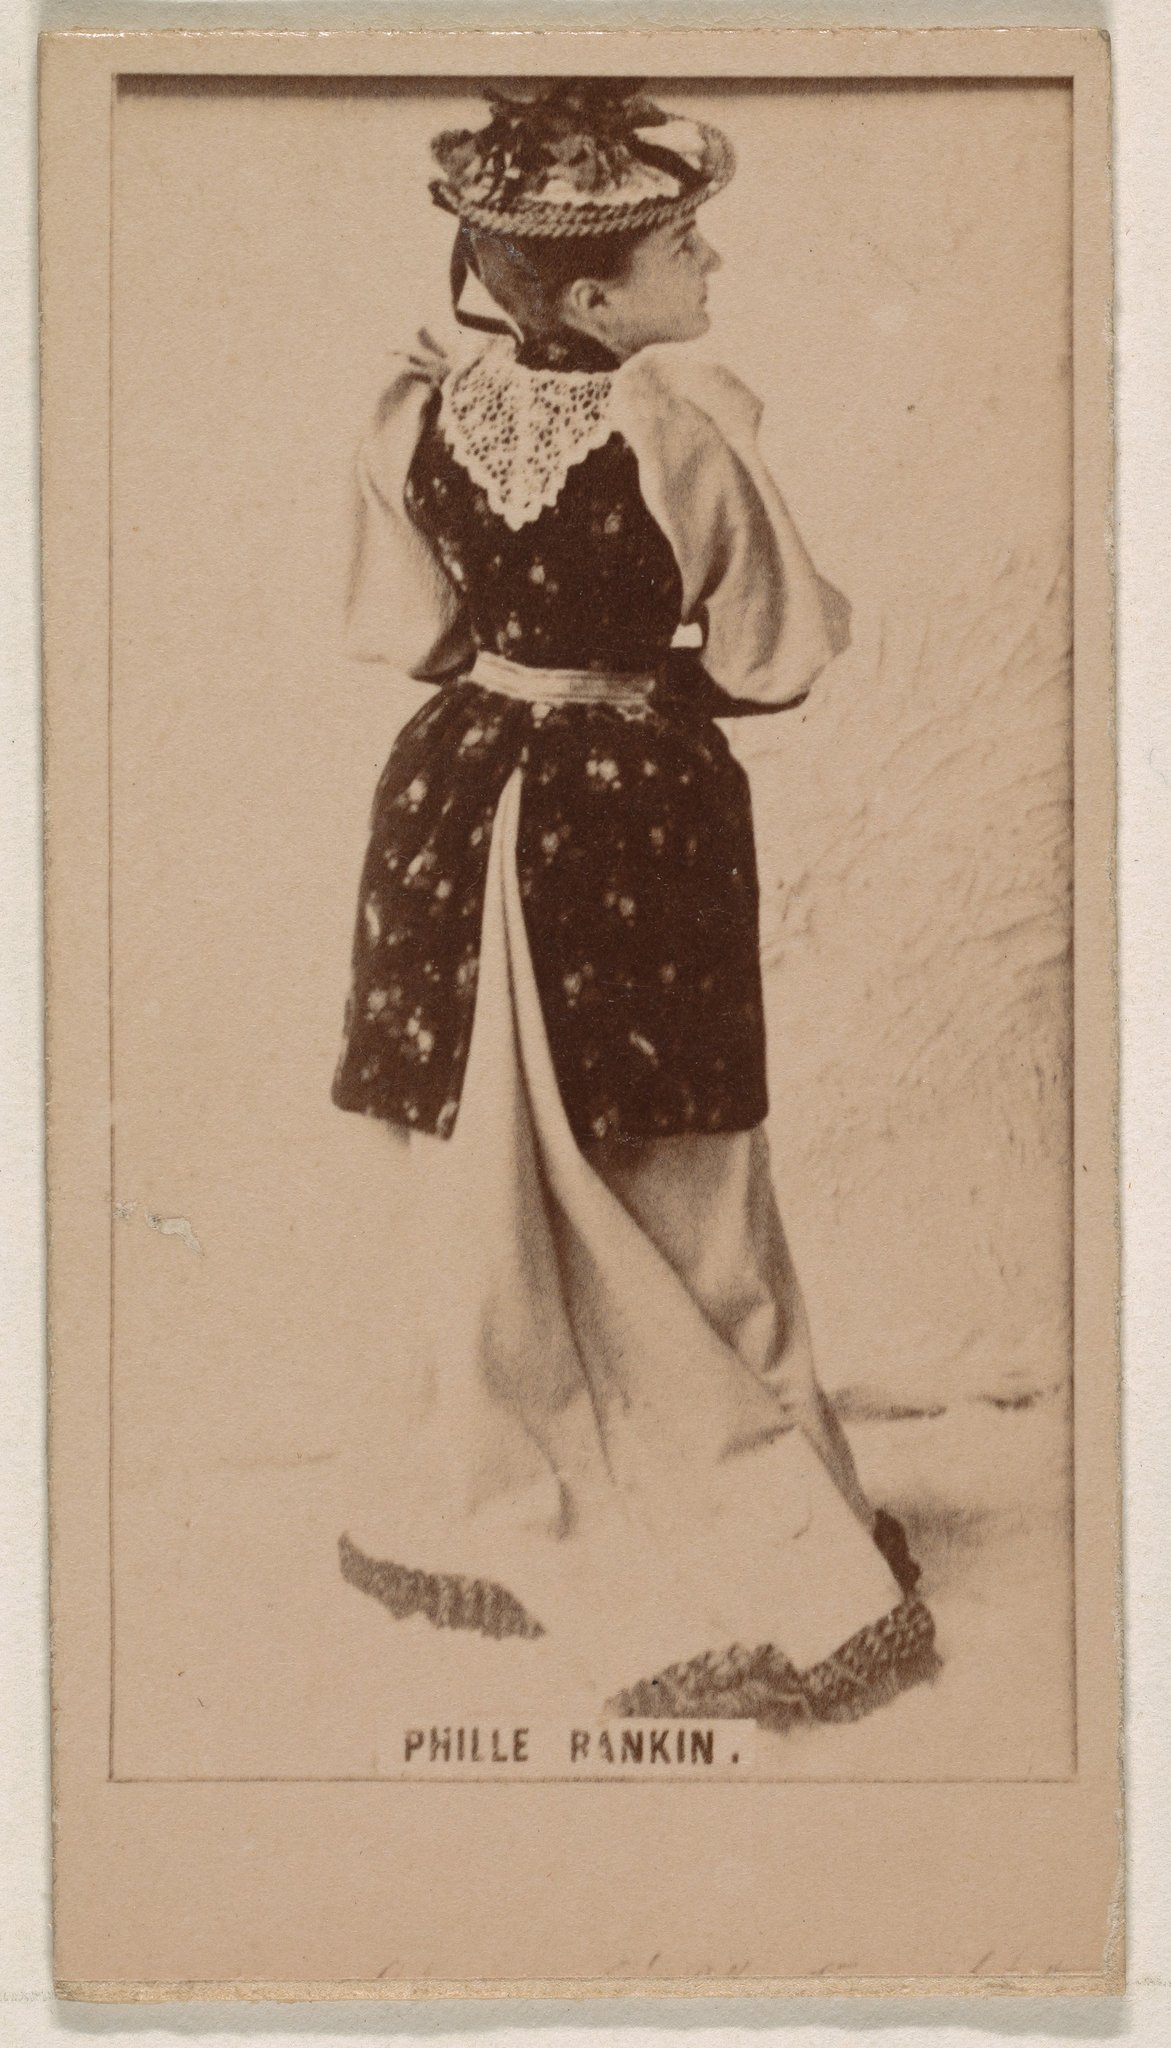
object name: photograph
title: Phille Rankin, from the Actresses series (N245) issued by Kinney Brothers to promote Sweet Caporal Cigarettes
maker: kinney brothers tobacco company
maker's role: publisher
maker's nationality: american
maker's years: 1869-2011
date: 1890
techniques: albumen silver print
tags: women,actresses